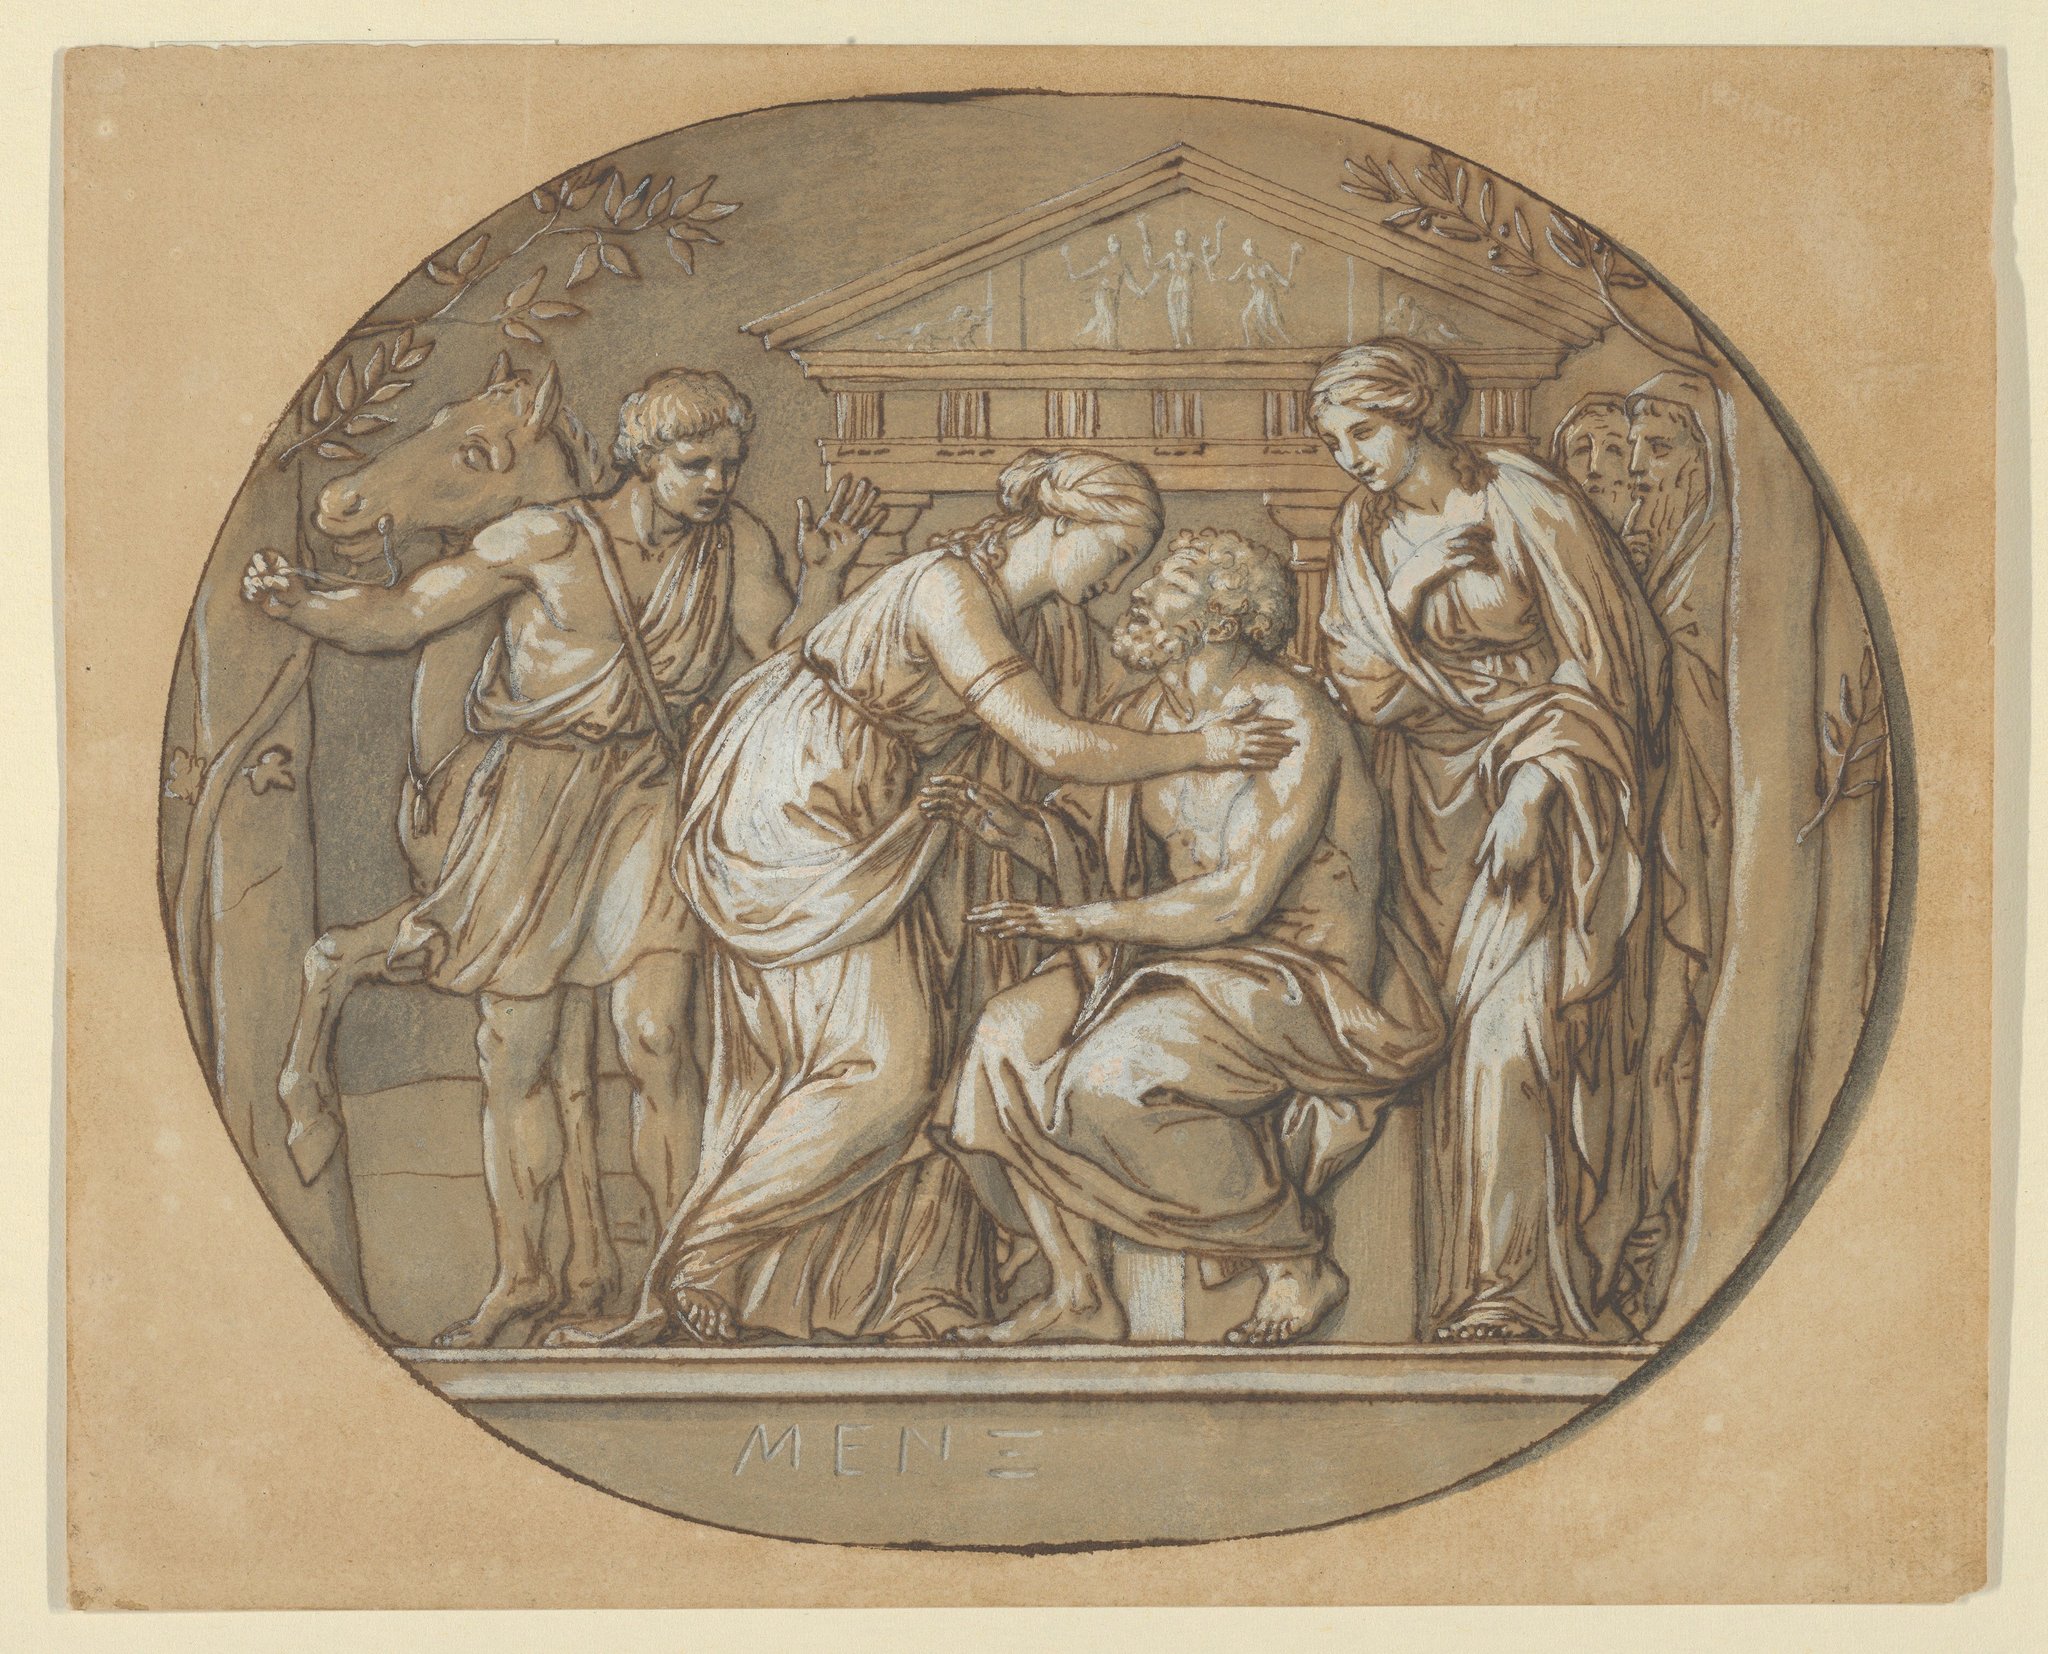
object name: drawing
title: Oedipus before the Temple of the Furies between his Daughters Antigone and Ismene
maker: anton raphael mengs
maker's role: artist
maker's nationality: german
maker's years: 1728-1779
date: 1760-1761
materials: gouache, graphite, ink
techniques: heightening, pen, wash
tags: men,women,horses